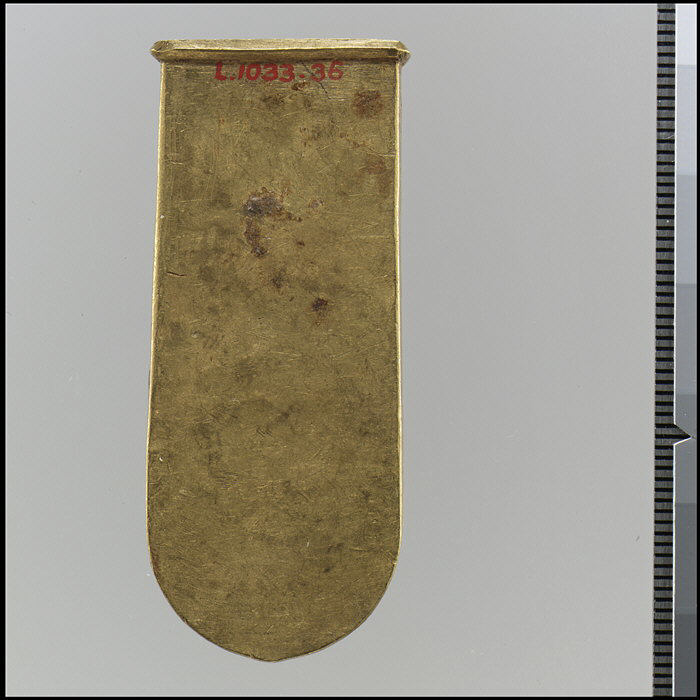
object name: belt strap end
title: Gold Strap End (Unfinished)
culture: avar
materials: gold